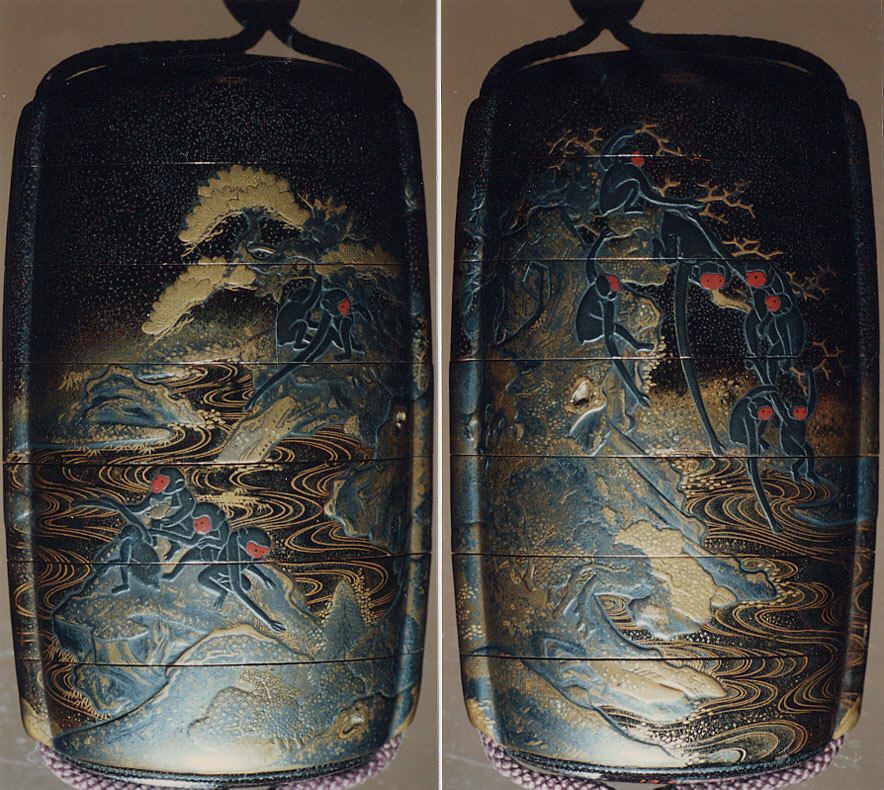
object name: inrō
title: Case (Inrō) with Design of Monkeys Hanging from Trees Above Waves (obverse); Monkeys Seated on Rocks (reverse)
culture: japanese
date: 1701-1900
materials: gold, lacquer, silver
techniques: fundame, hiramakie, roiro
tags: monkeys,trees,waves